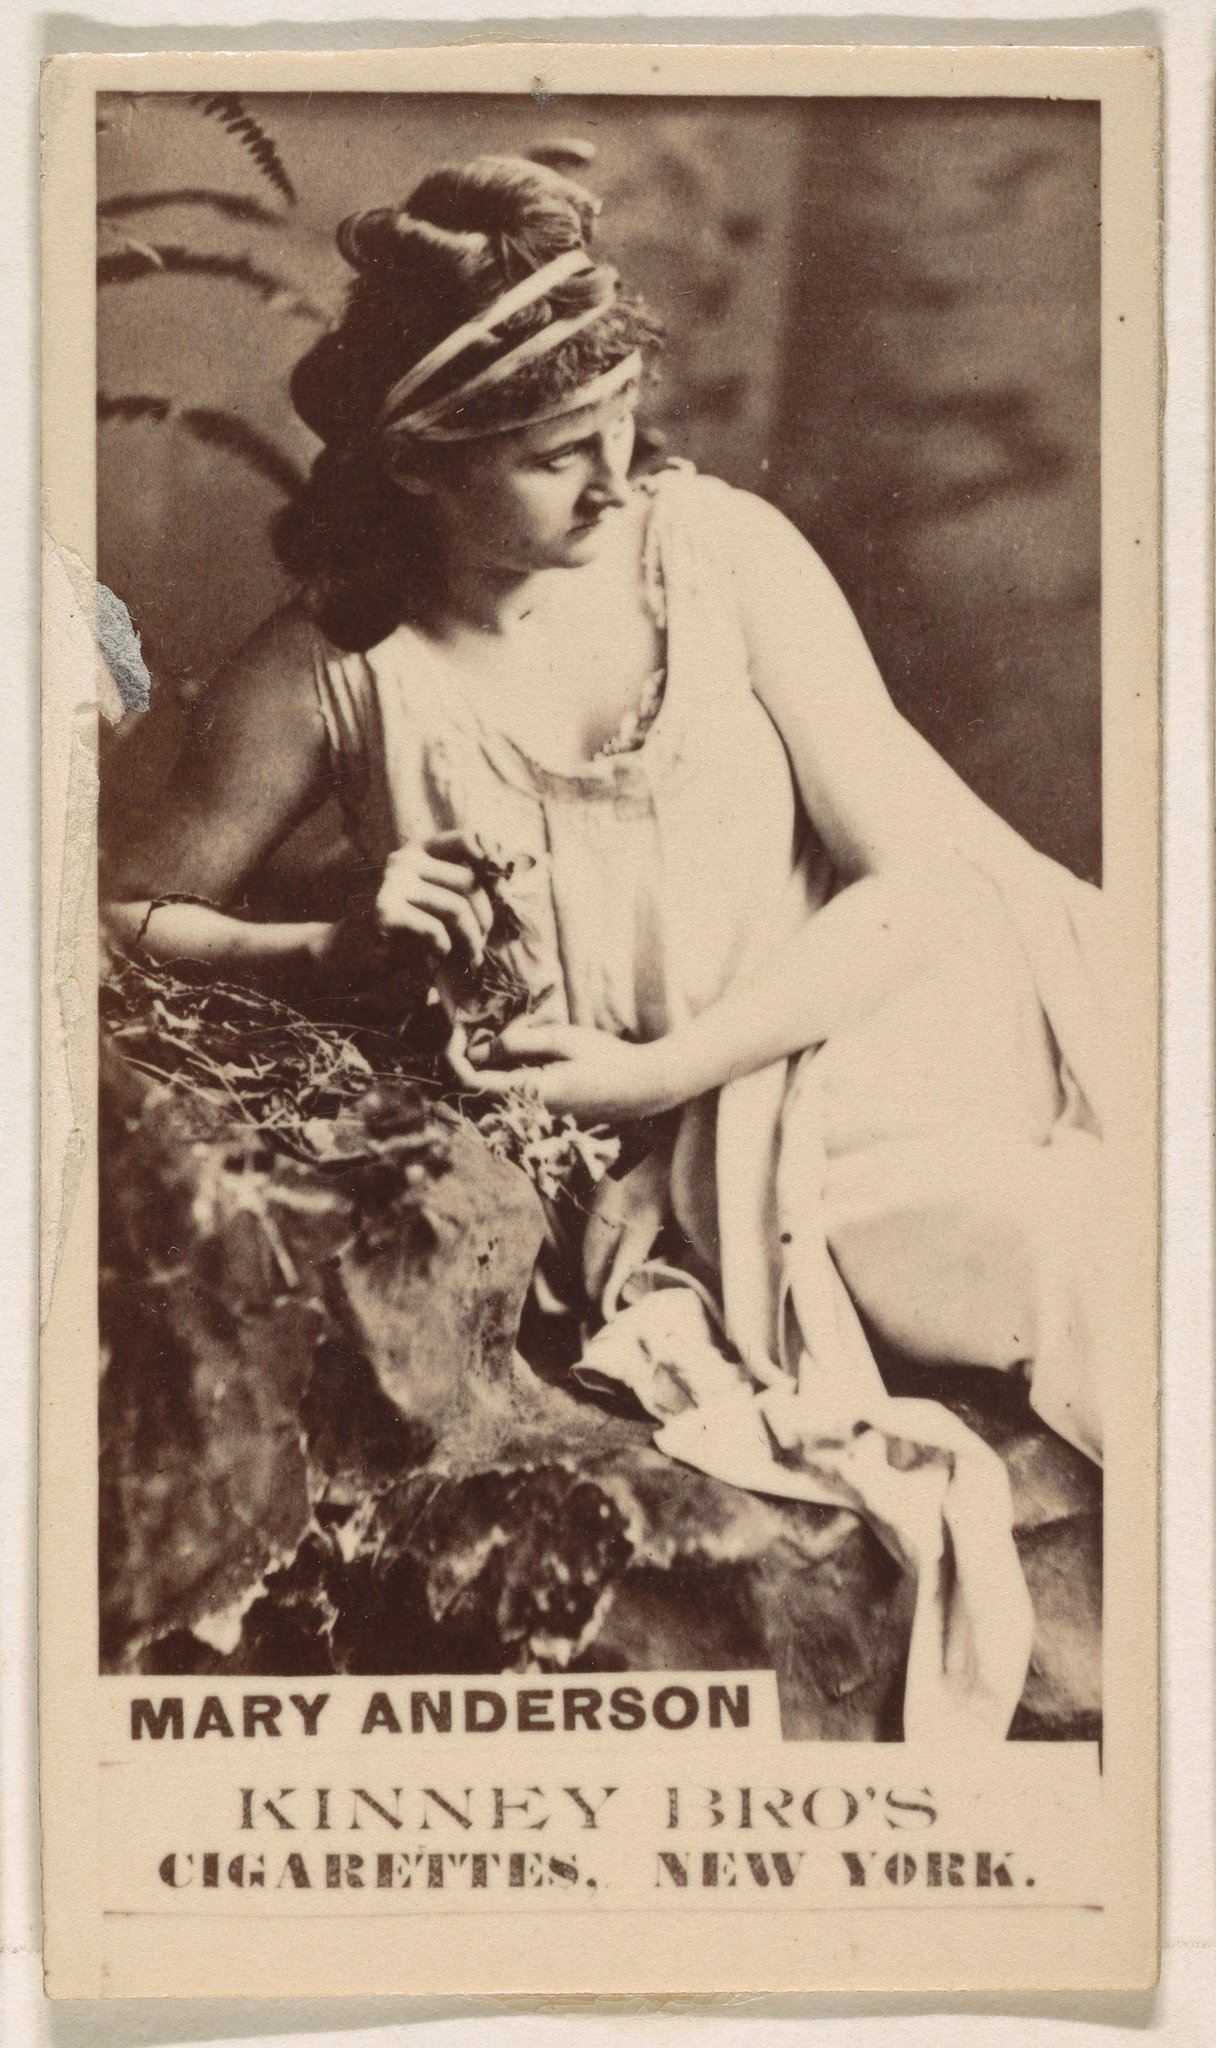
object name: photograph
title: Mary Anderson, from the Actresses series (N245) issued by Kinney Brothers to promote Sweet Caporal Cigarettes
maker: kinney brothers tobacco company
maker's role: publisher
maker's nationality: american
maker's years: 1869-2011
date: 1890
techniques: albumen silver print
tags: portraits,women,actresses